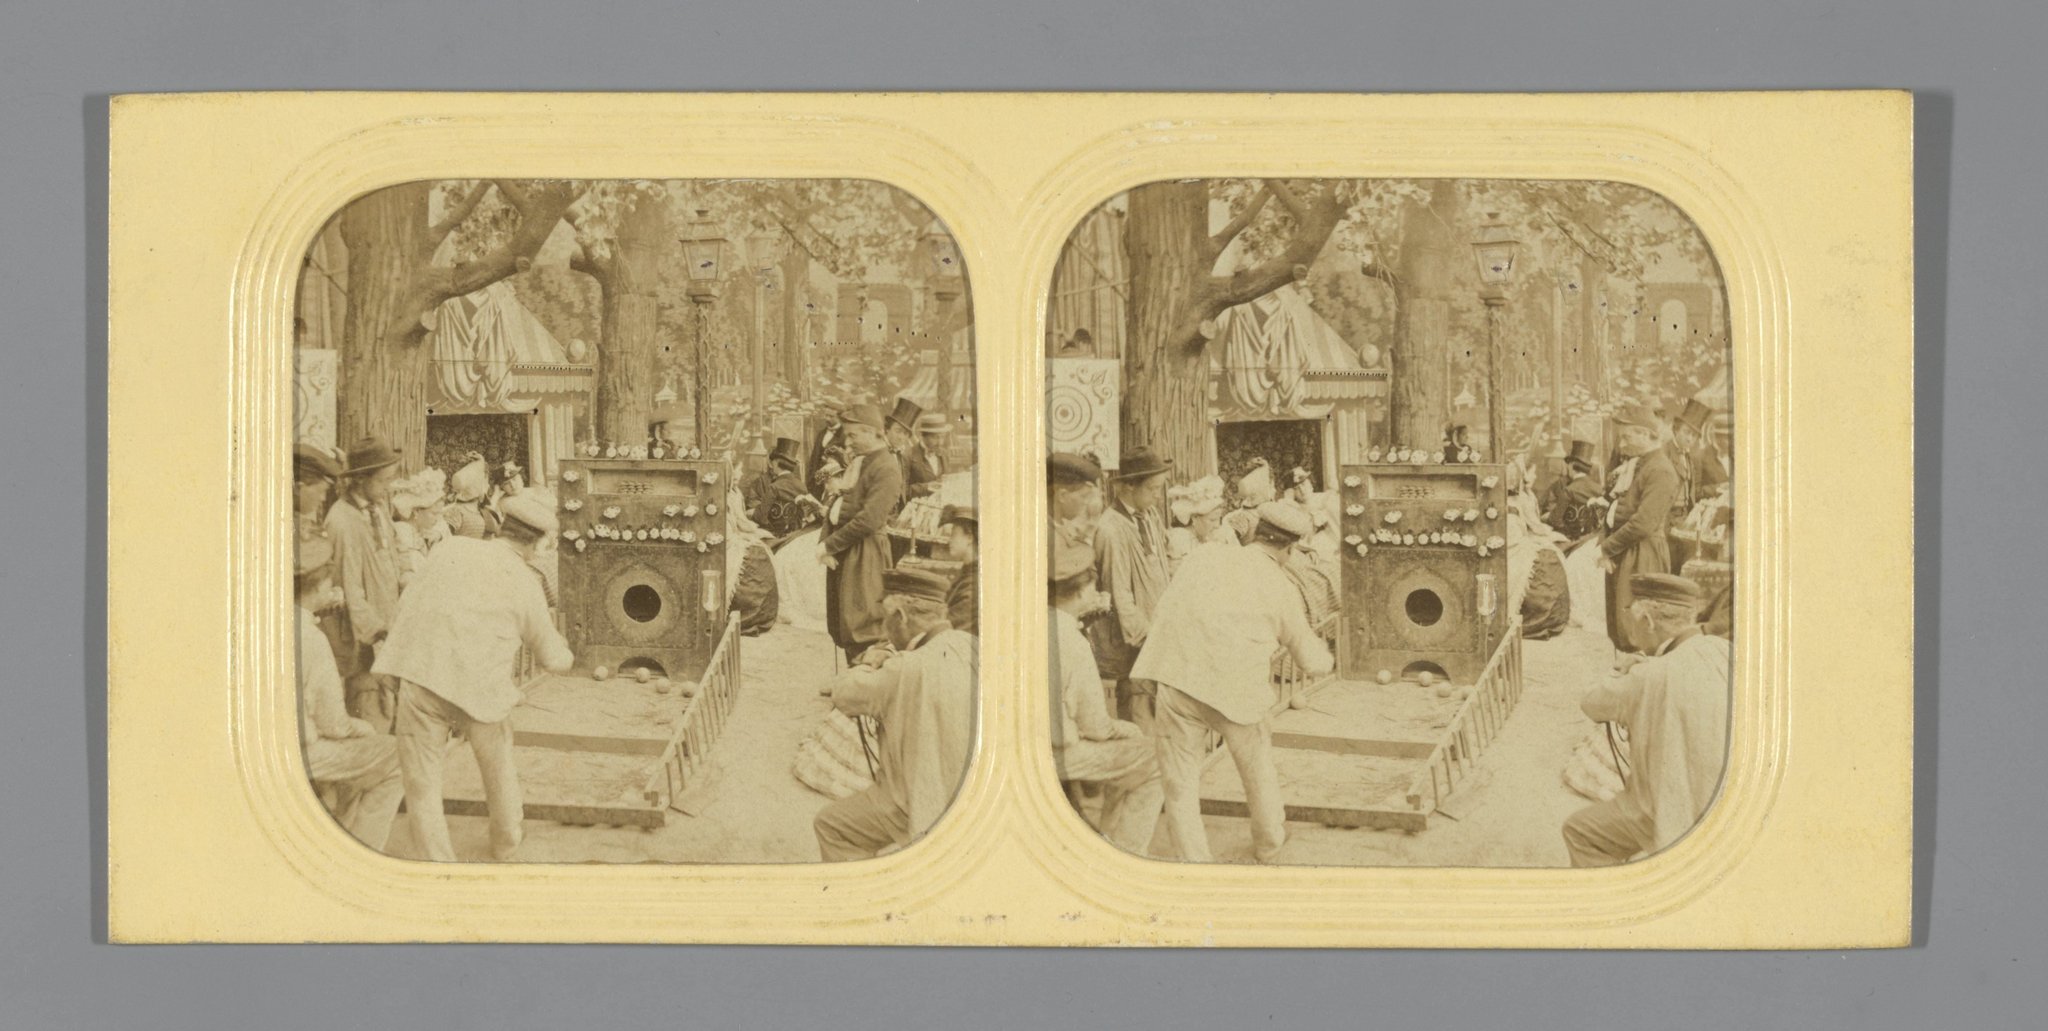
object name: tissue stereograph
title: Ballenspel op een kermis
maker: Anonymous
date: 1855-1875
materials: cardboard, paper, photographic support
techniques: albumen print, cutting, hand coloring, perforating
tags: ball games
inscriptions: number: ‘89’